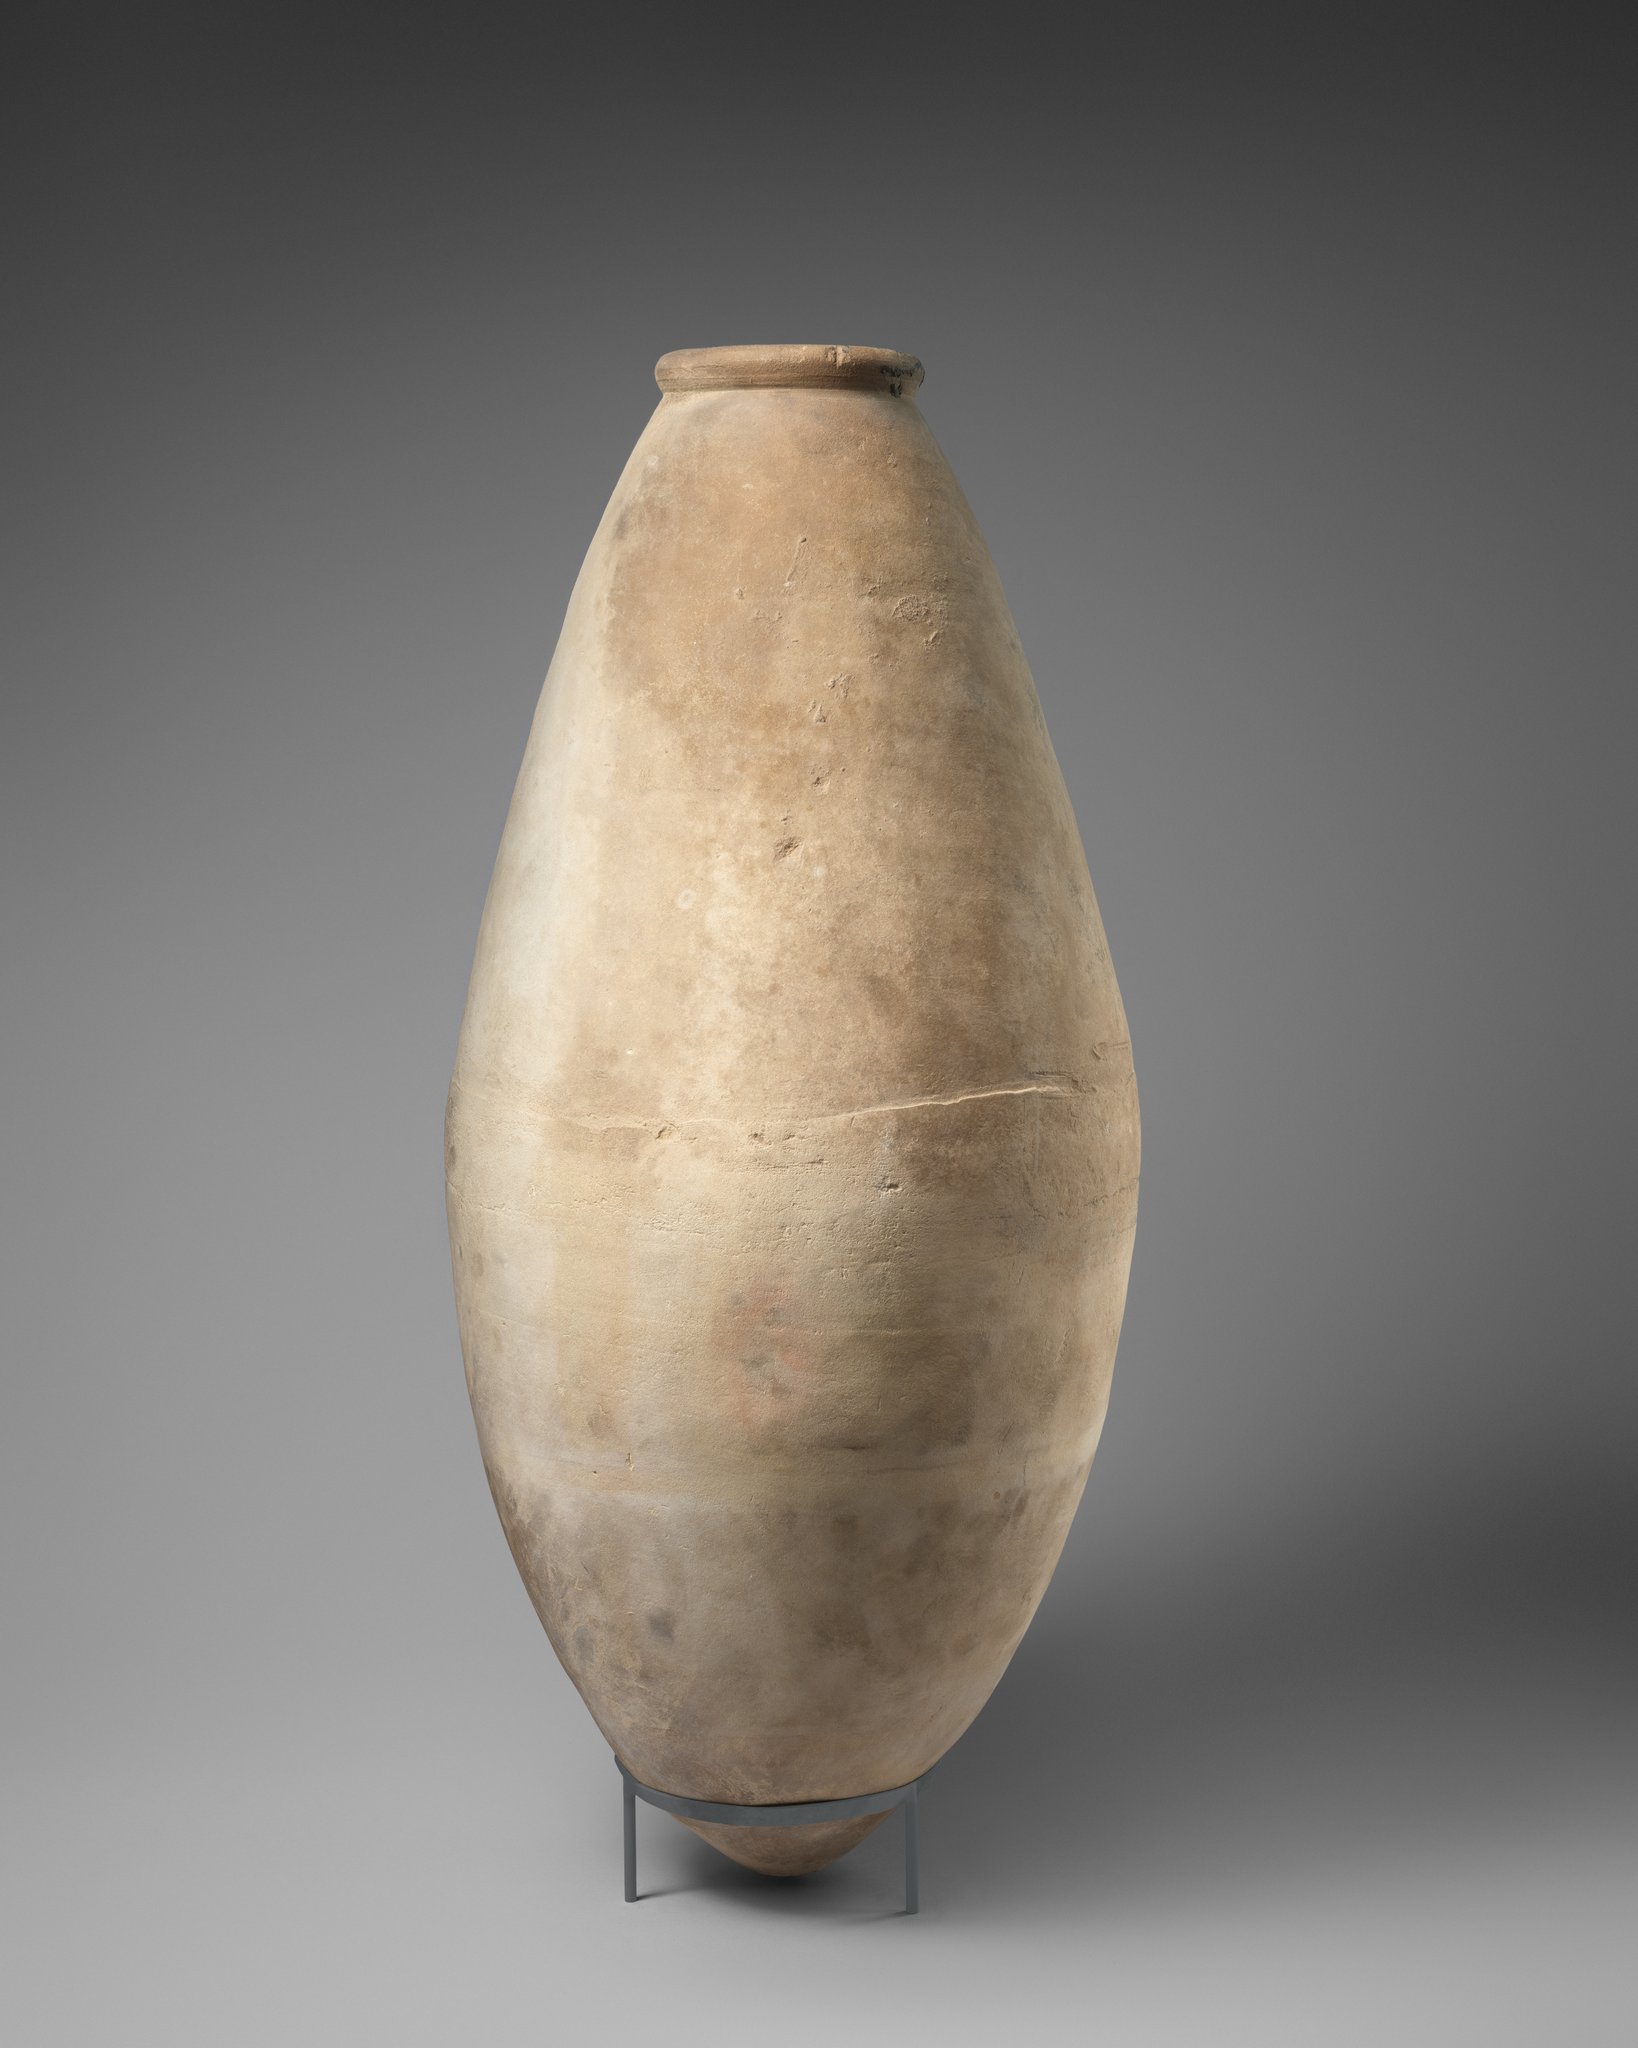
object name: jar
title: Storage jar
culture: sasanian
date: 201-700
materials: ceramic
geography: mesopotamia